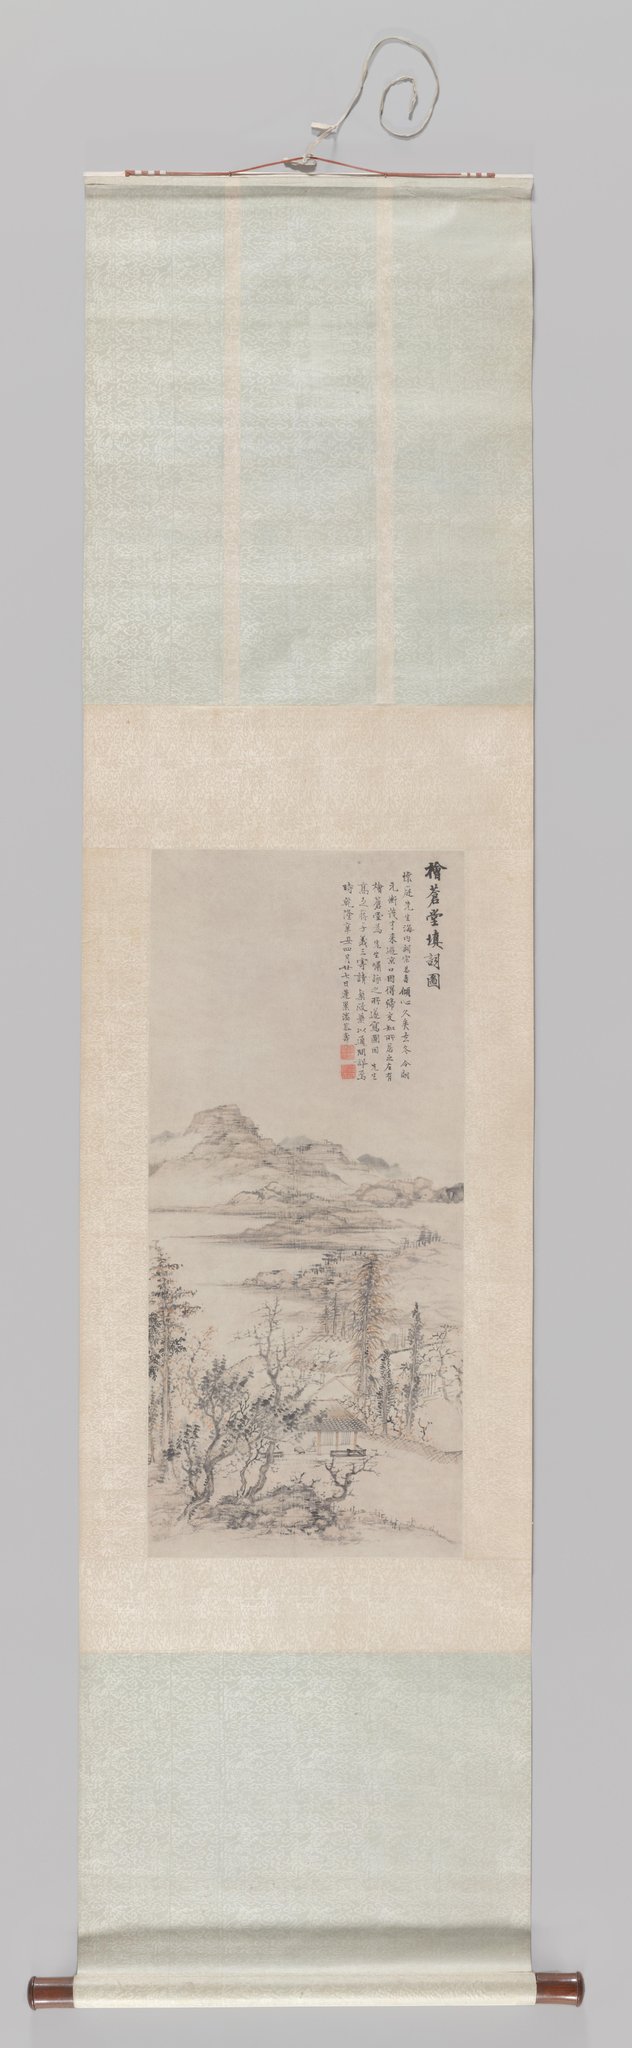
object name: tablecloth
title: Tafellaken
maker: Anonymous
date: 1885-1896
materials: linen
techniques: damask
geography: germany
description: Wit linnen damasten tafellaken met acanthusvoluten en het wapen Gevers van Kethel en Spaland en het gekroonde monogram G.